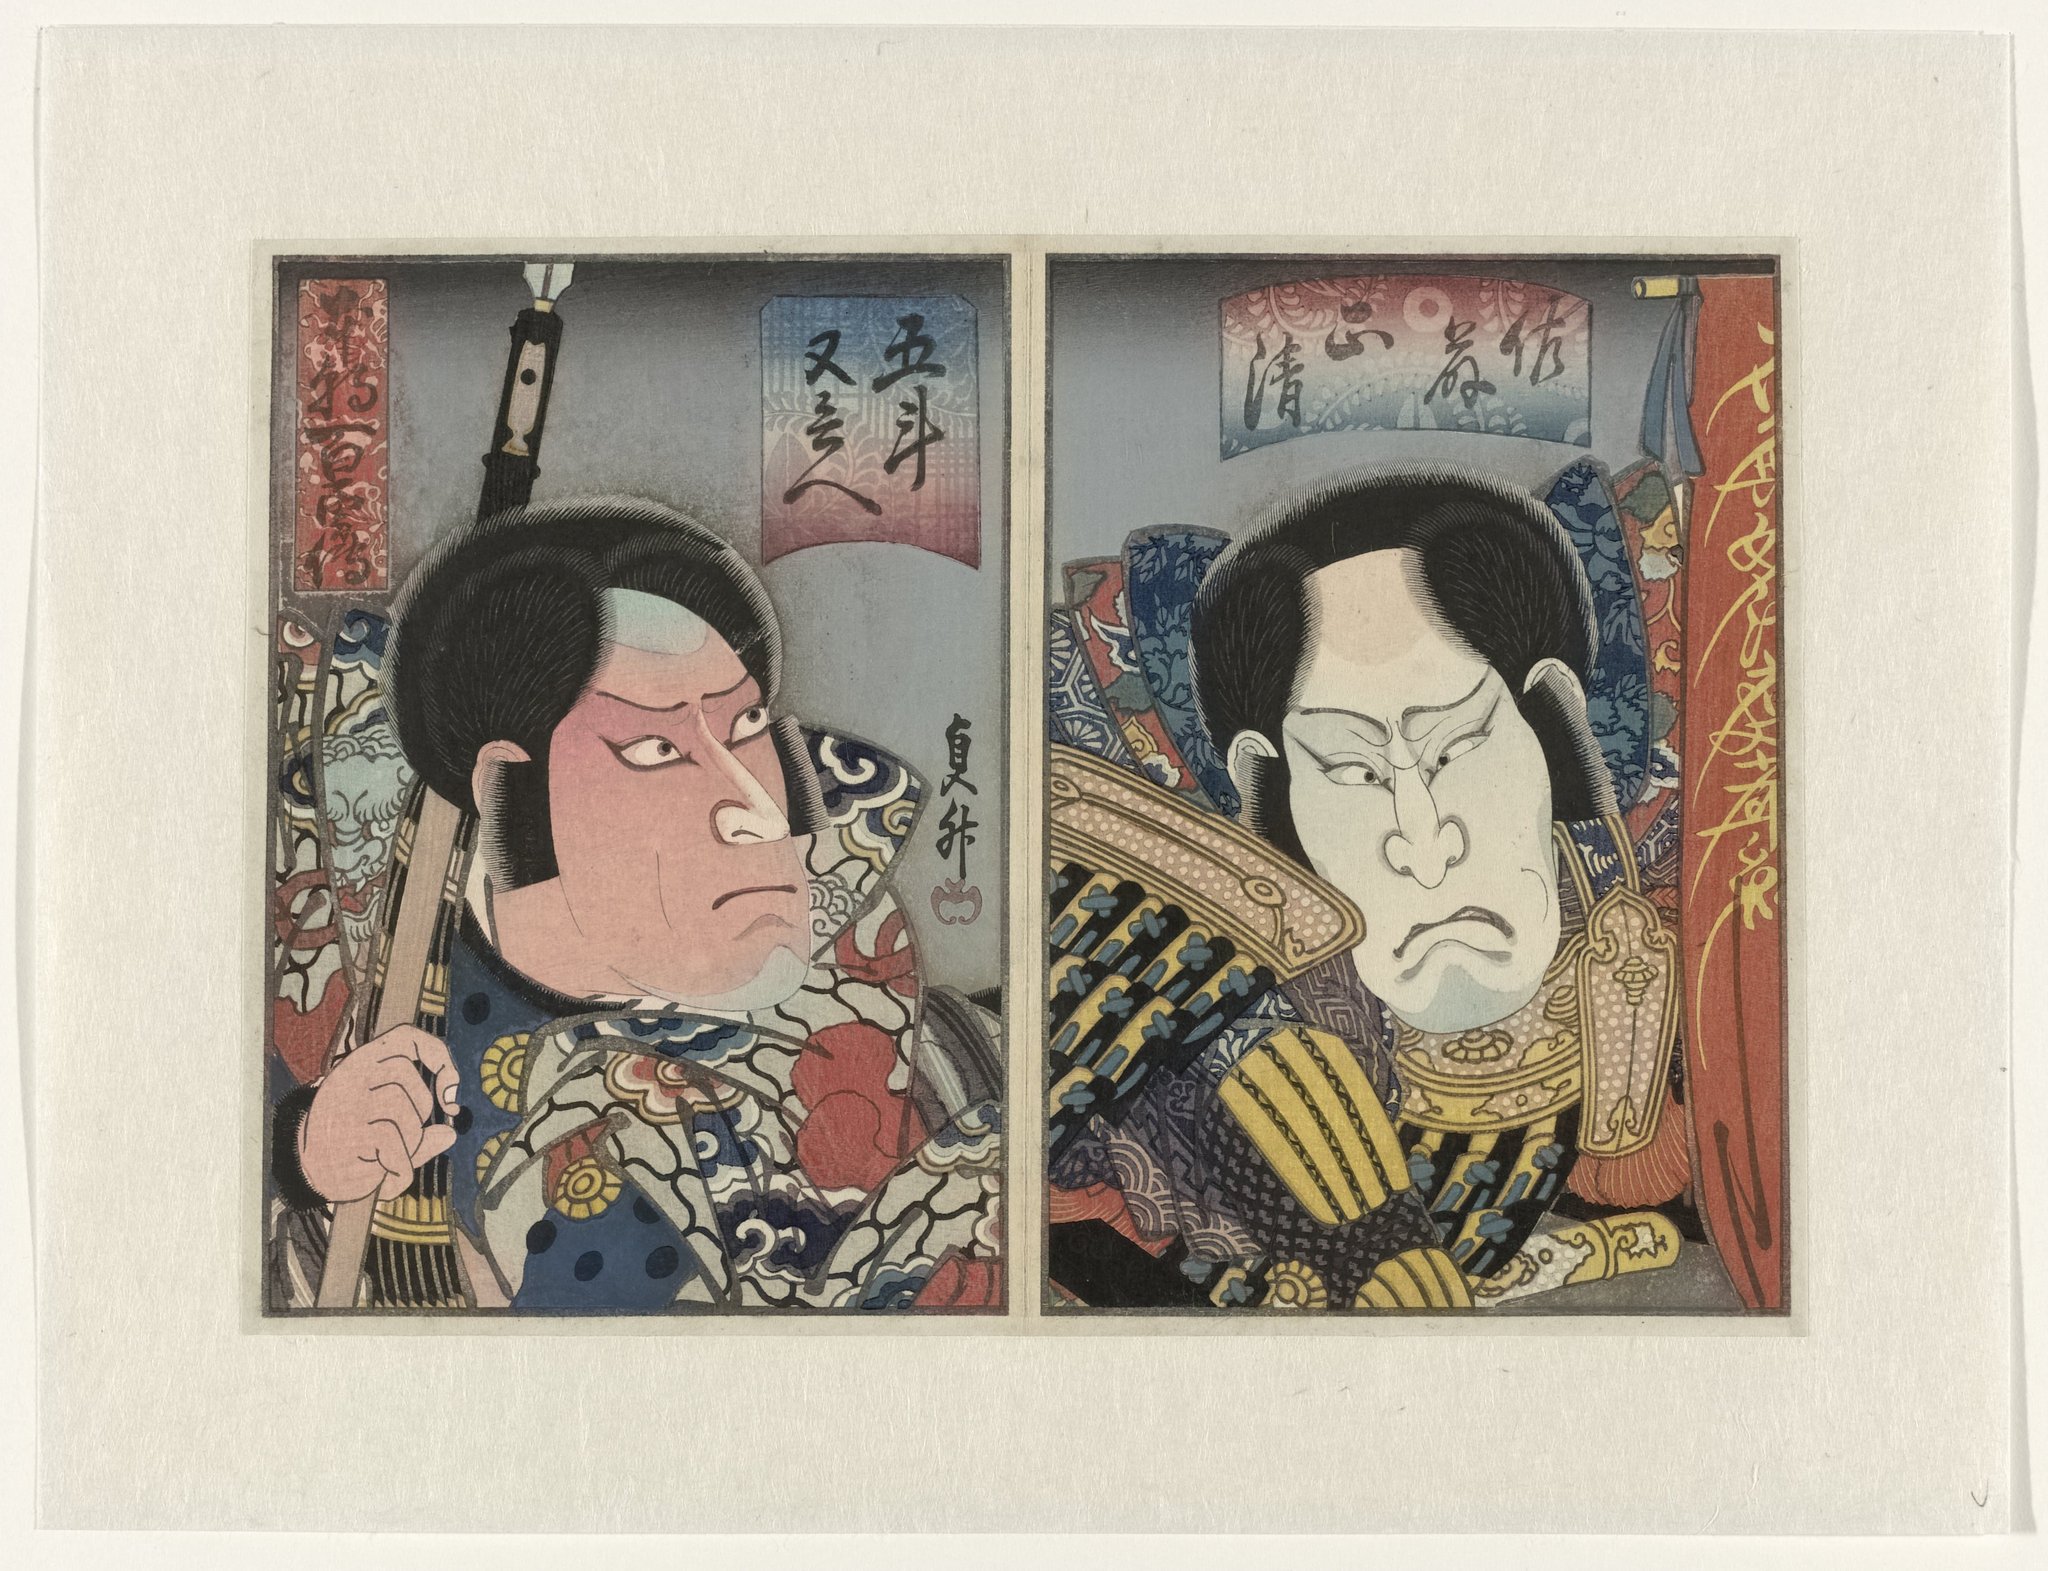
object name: print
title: Honderd verhalen over moed, uit eigen land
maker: utagawa sadamasu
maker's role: print maker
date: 1847-1848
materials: paper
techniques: woodcut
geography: osaka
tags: portrait of actor, actress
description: Ichikawa Ebijûrô IV (vanaf 1847 tot 4/1849 genaamd Bandô Jutarô II) als Gotobei, en Kataoka Ichizô I (frontaal in beeld) als Sato Masakiyo. Chûban met koban diptiek